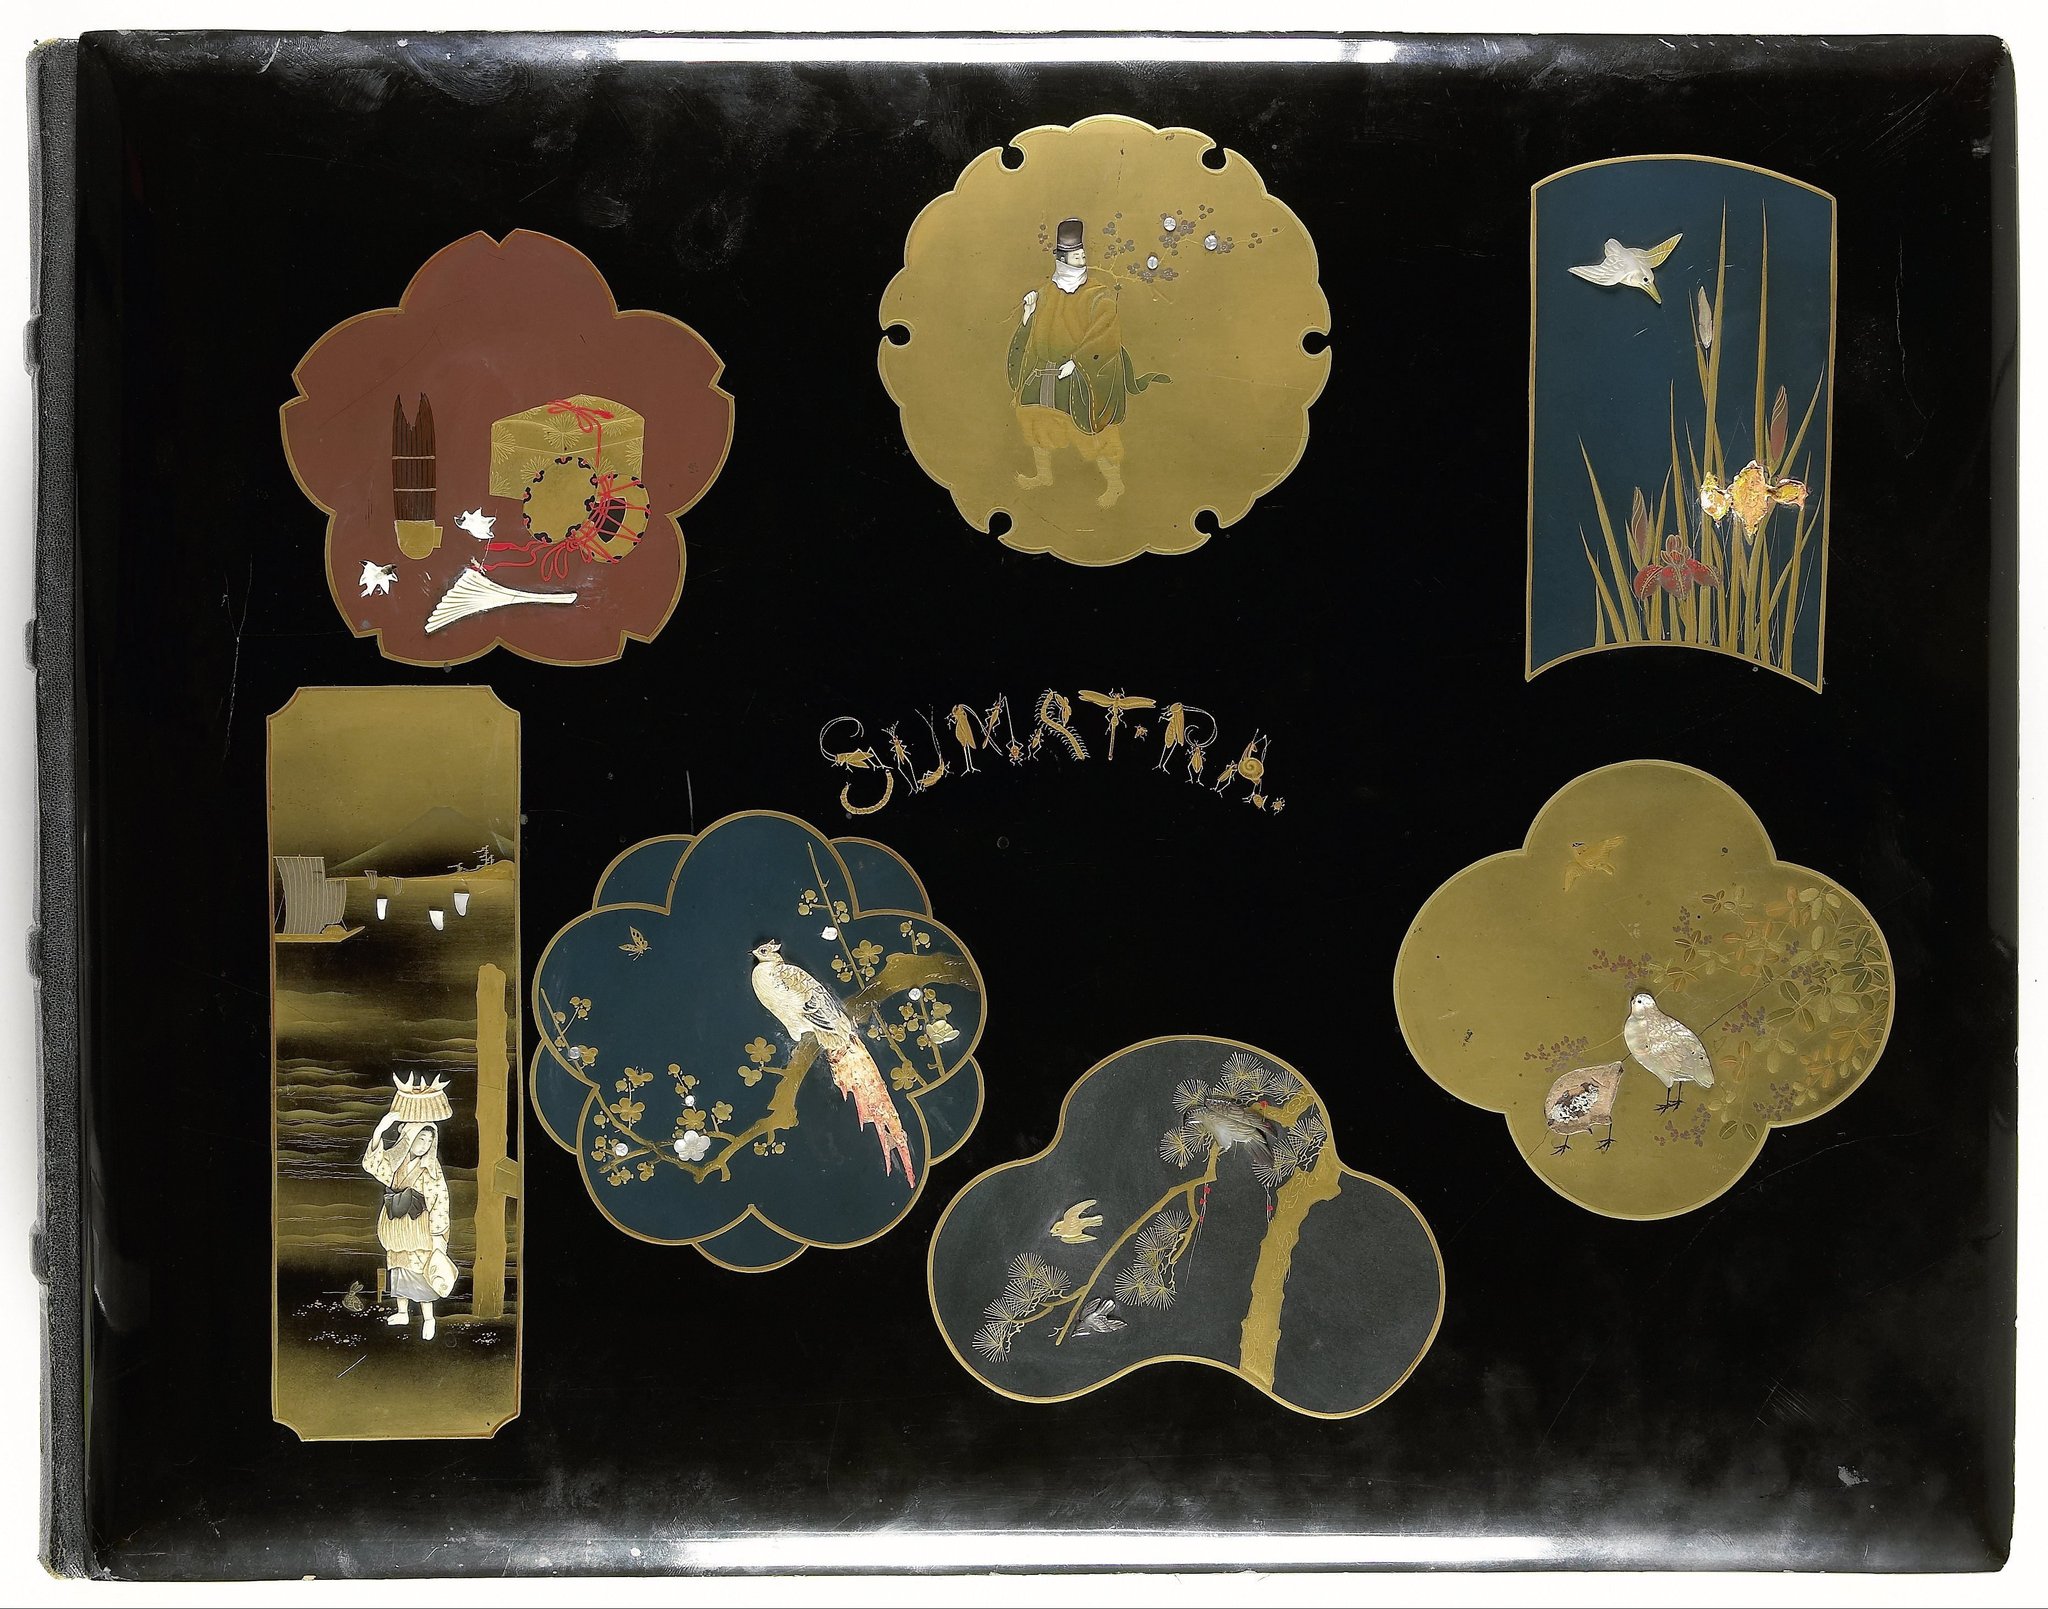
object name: photograph album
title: Cover of 'Sumatra' album belonging to Paul and Lucie Sandel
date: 1900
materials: cardboard, lacquer, mother of pearl, paper, photographic support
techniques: albumen print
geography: medan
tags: lucie sandel, sumatra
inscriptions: annotation: ‘David den lieben Neuvermählten Paul & Lucie Langkat, Januar 1900.’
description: Fotoalbum geschonken aan Paul en Lucie Sandel te Langkat op Sumatra ter gelegenheid van hun huwelijk in januari 1900 door Pauls broer David Sandel. Band op voor- en achterzijde versierd met platen Cantonees lakwerk met inlegwerk. Voorzijde: opschrift "Sumatra" en zeven cartouches met Japanse motieven: natuurscènes met vogels en bloemen, stilleven van voorwerpen en Indonesische mensen. Achterzijde met ganzen vliegend langs maan en grashalmen. Het album bevat 25 bladen van zwaar karton met goud op snee met 50 foto's geplakt op beide zijden. Bij het album een handgeschreven inhoudsopgave in het Duits en een foto van Paul en Lucie Sandel.